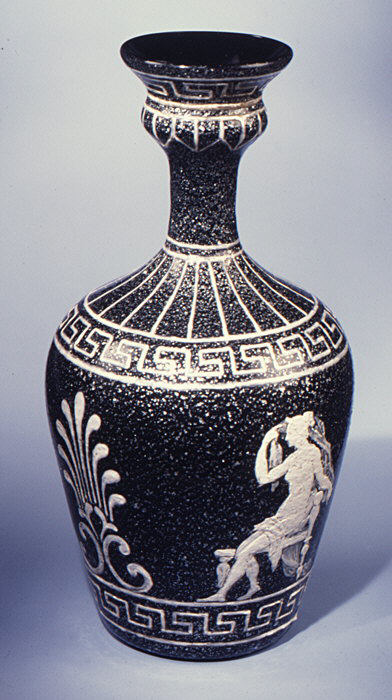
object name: vase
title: Mercury with a seated lady (Herse?)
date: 1801-1900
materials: glass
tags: mercury